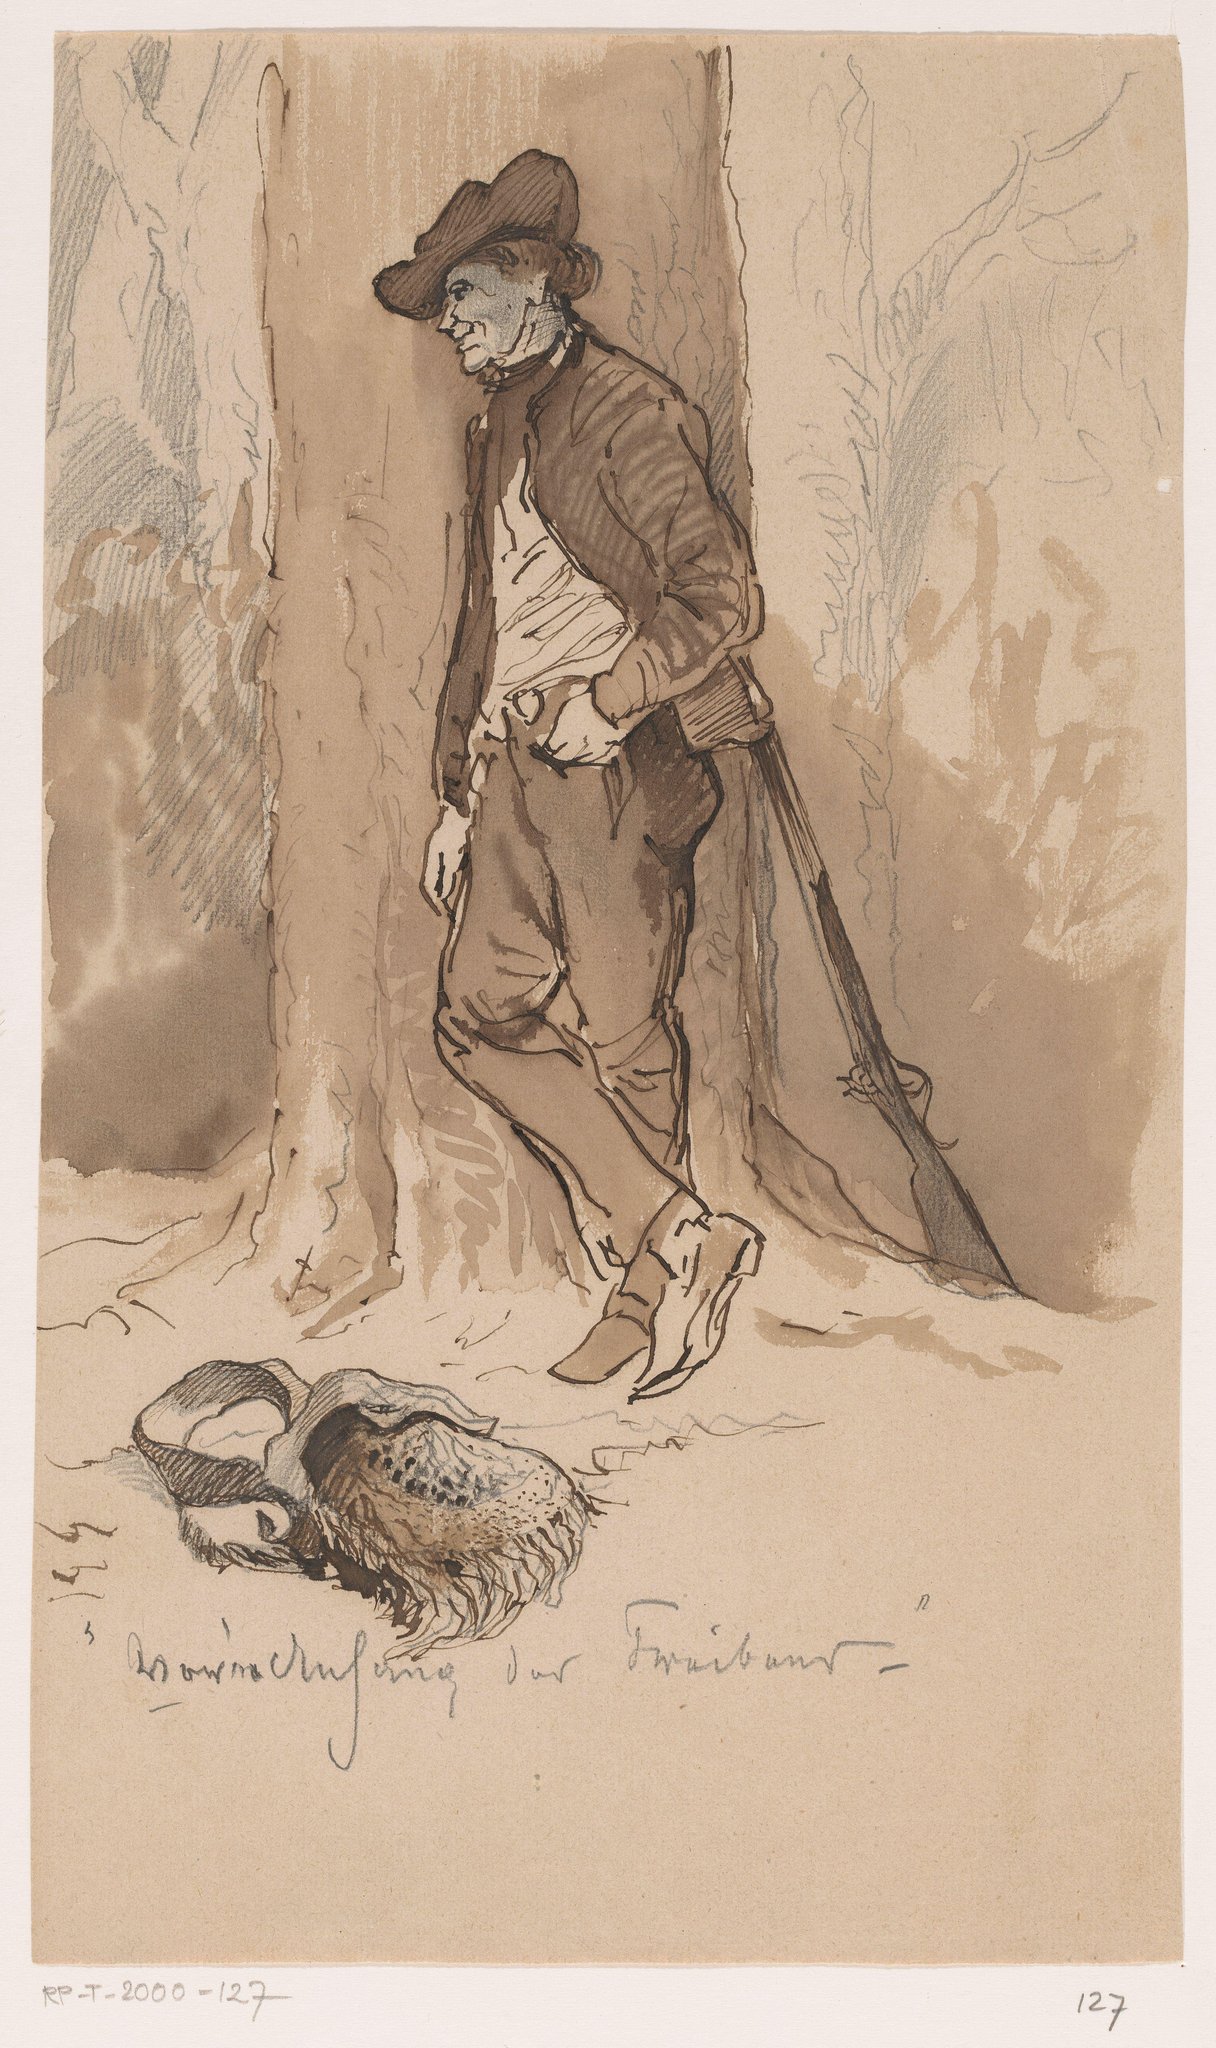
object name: drawing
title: Jager leunend tegen een boom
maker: johannes tavenraat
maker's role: draughtsman, painter, print maker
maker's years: 1809-1881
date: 1840-1870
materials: ink, paper, pencil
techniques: brush, pen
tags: hunters resting during the hunt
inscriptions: collector's mark: Lugt 2228, annotation:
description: Staande jager leunend tegen een boom, zijn geweer rust op de grond tegen de boom, op de voorgrond een weitas.